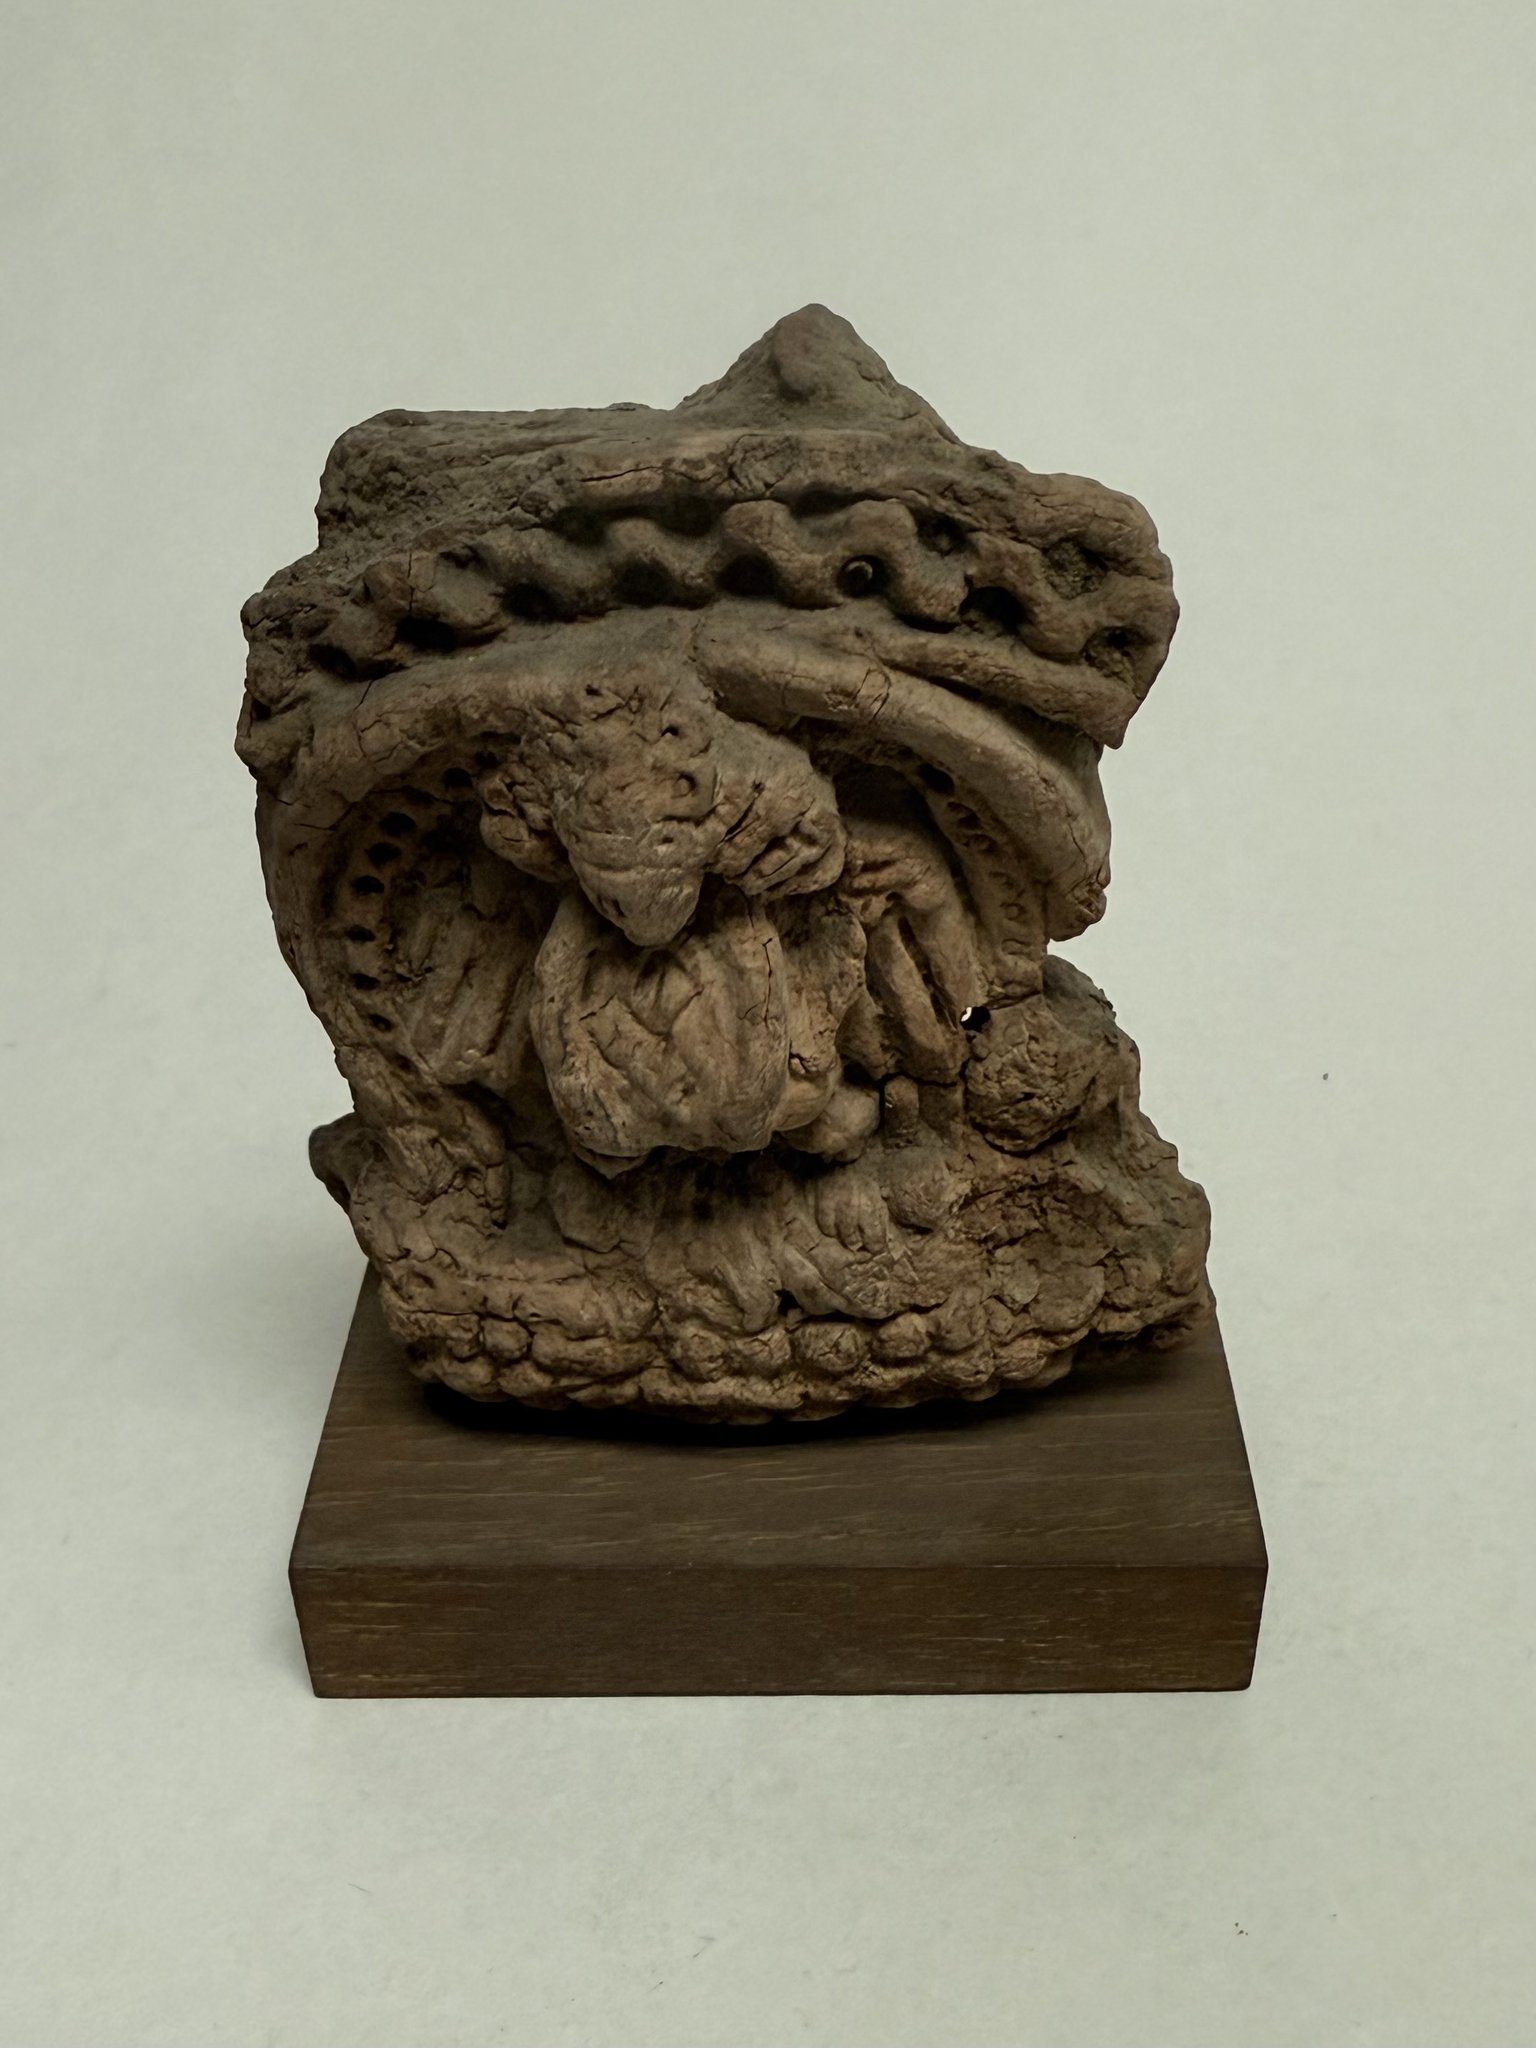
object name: relief fragment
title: Fragment of a Relief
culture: tibetan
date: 1401-1700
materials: clay